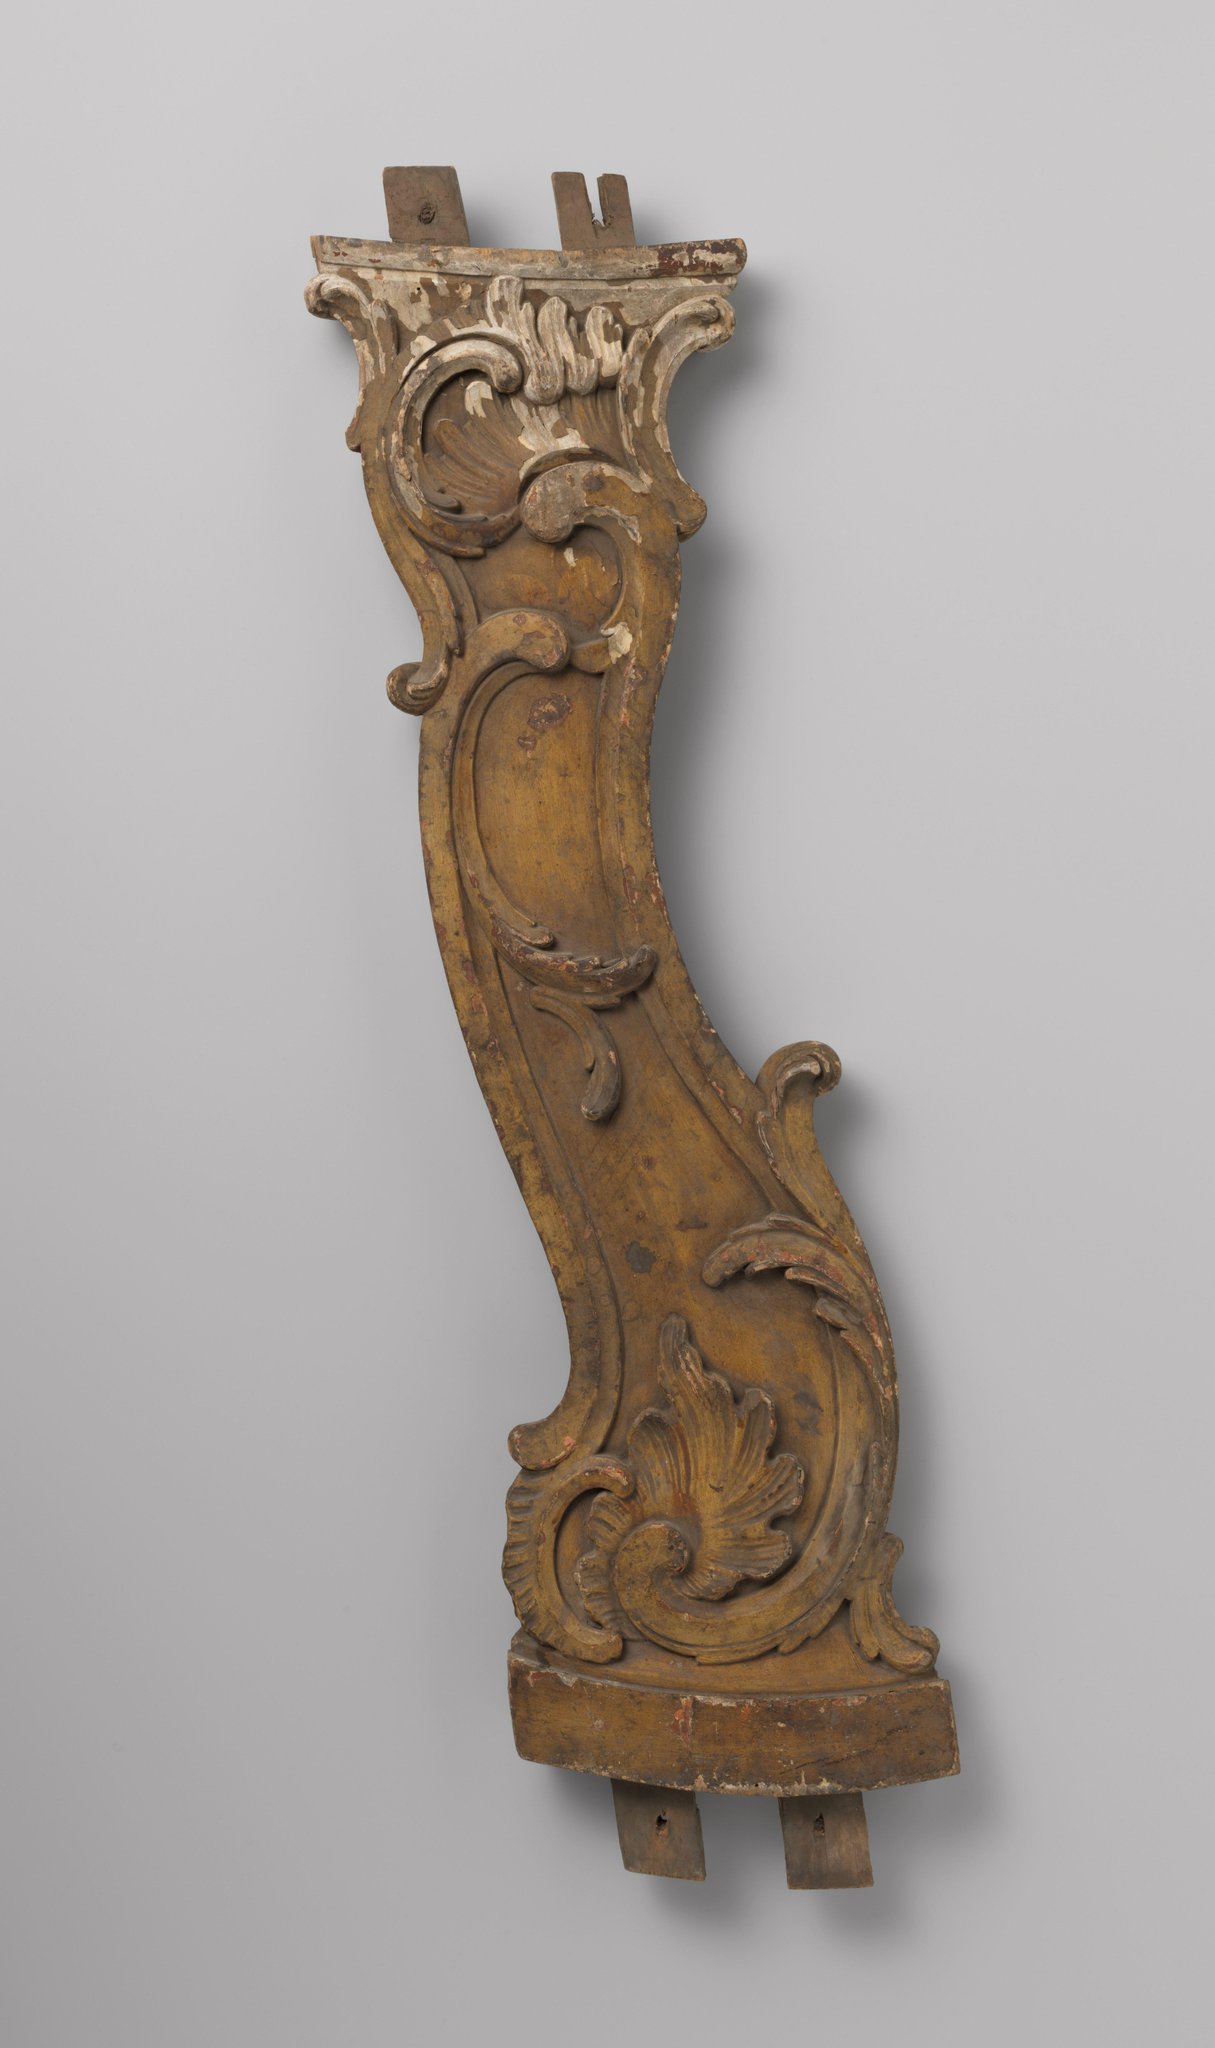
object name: trapbalustrade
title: Baluster met gestoken C- en S-voluten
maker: Anonymous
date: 1740-1760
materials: wood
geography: northern netherlands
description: S-vormige baluster met gestoken C- en S-voluten met rocaille-schelpen.